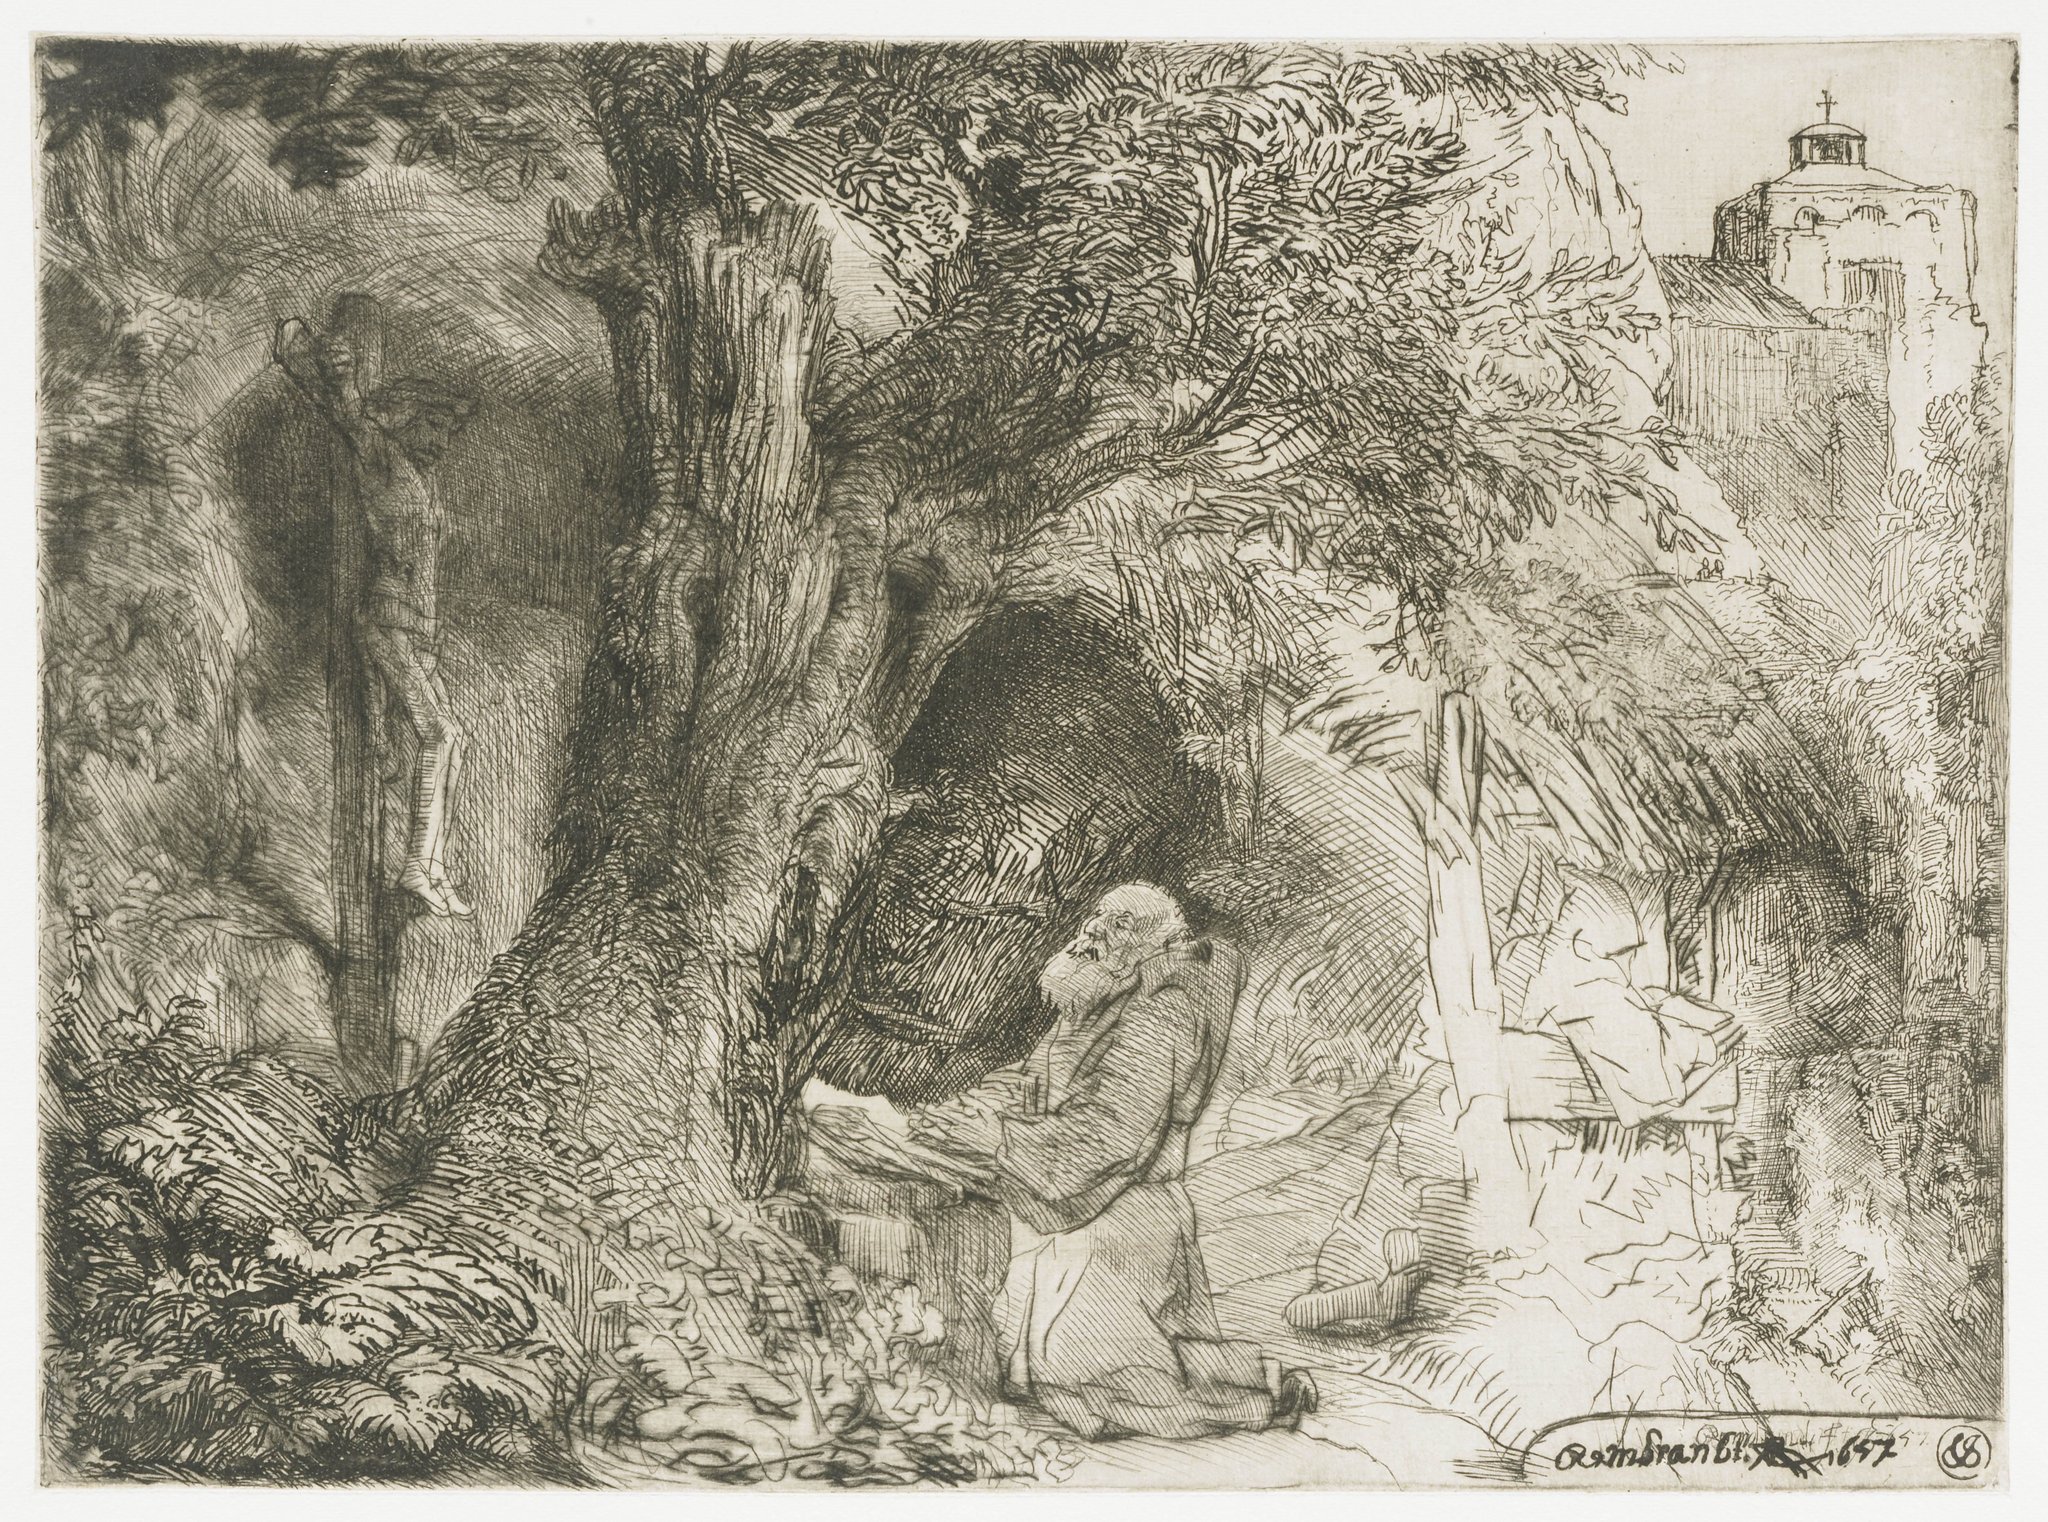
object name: print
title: St Francis beneath a tree praying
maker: rembrandt van rijn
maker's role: draughtsman, painter, print maker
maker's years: 1606-1669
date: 1657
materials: paper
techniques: drypoint, etching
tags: founder of the order of friars minor (franciscans), francis(cus) of assisi; possible attributes: book, crucifix, lily, skull, stigmata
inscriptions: mark: Lugt 573, signature and date: ‘Rembrandt f. 1657’, inscription: ‘10 St (?)’